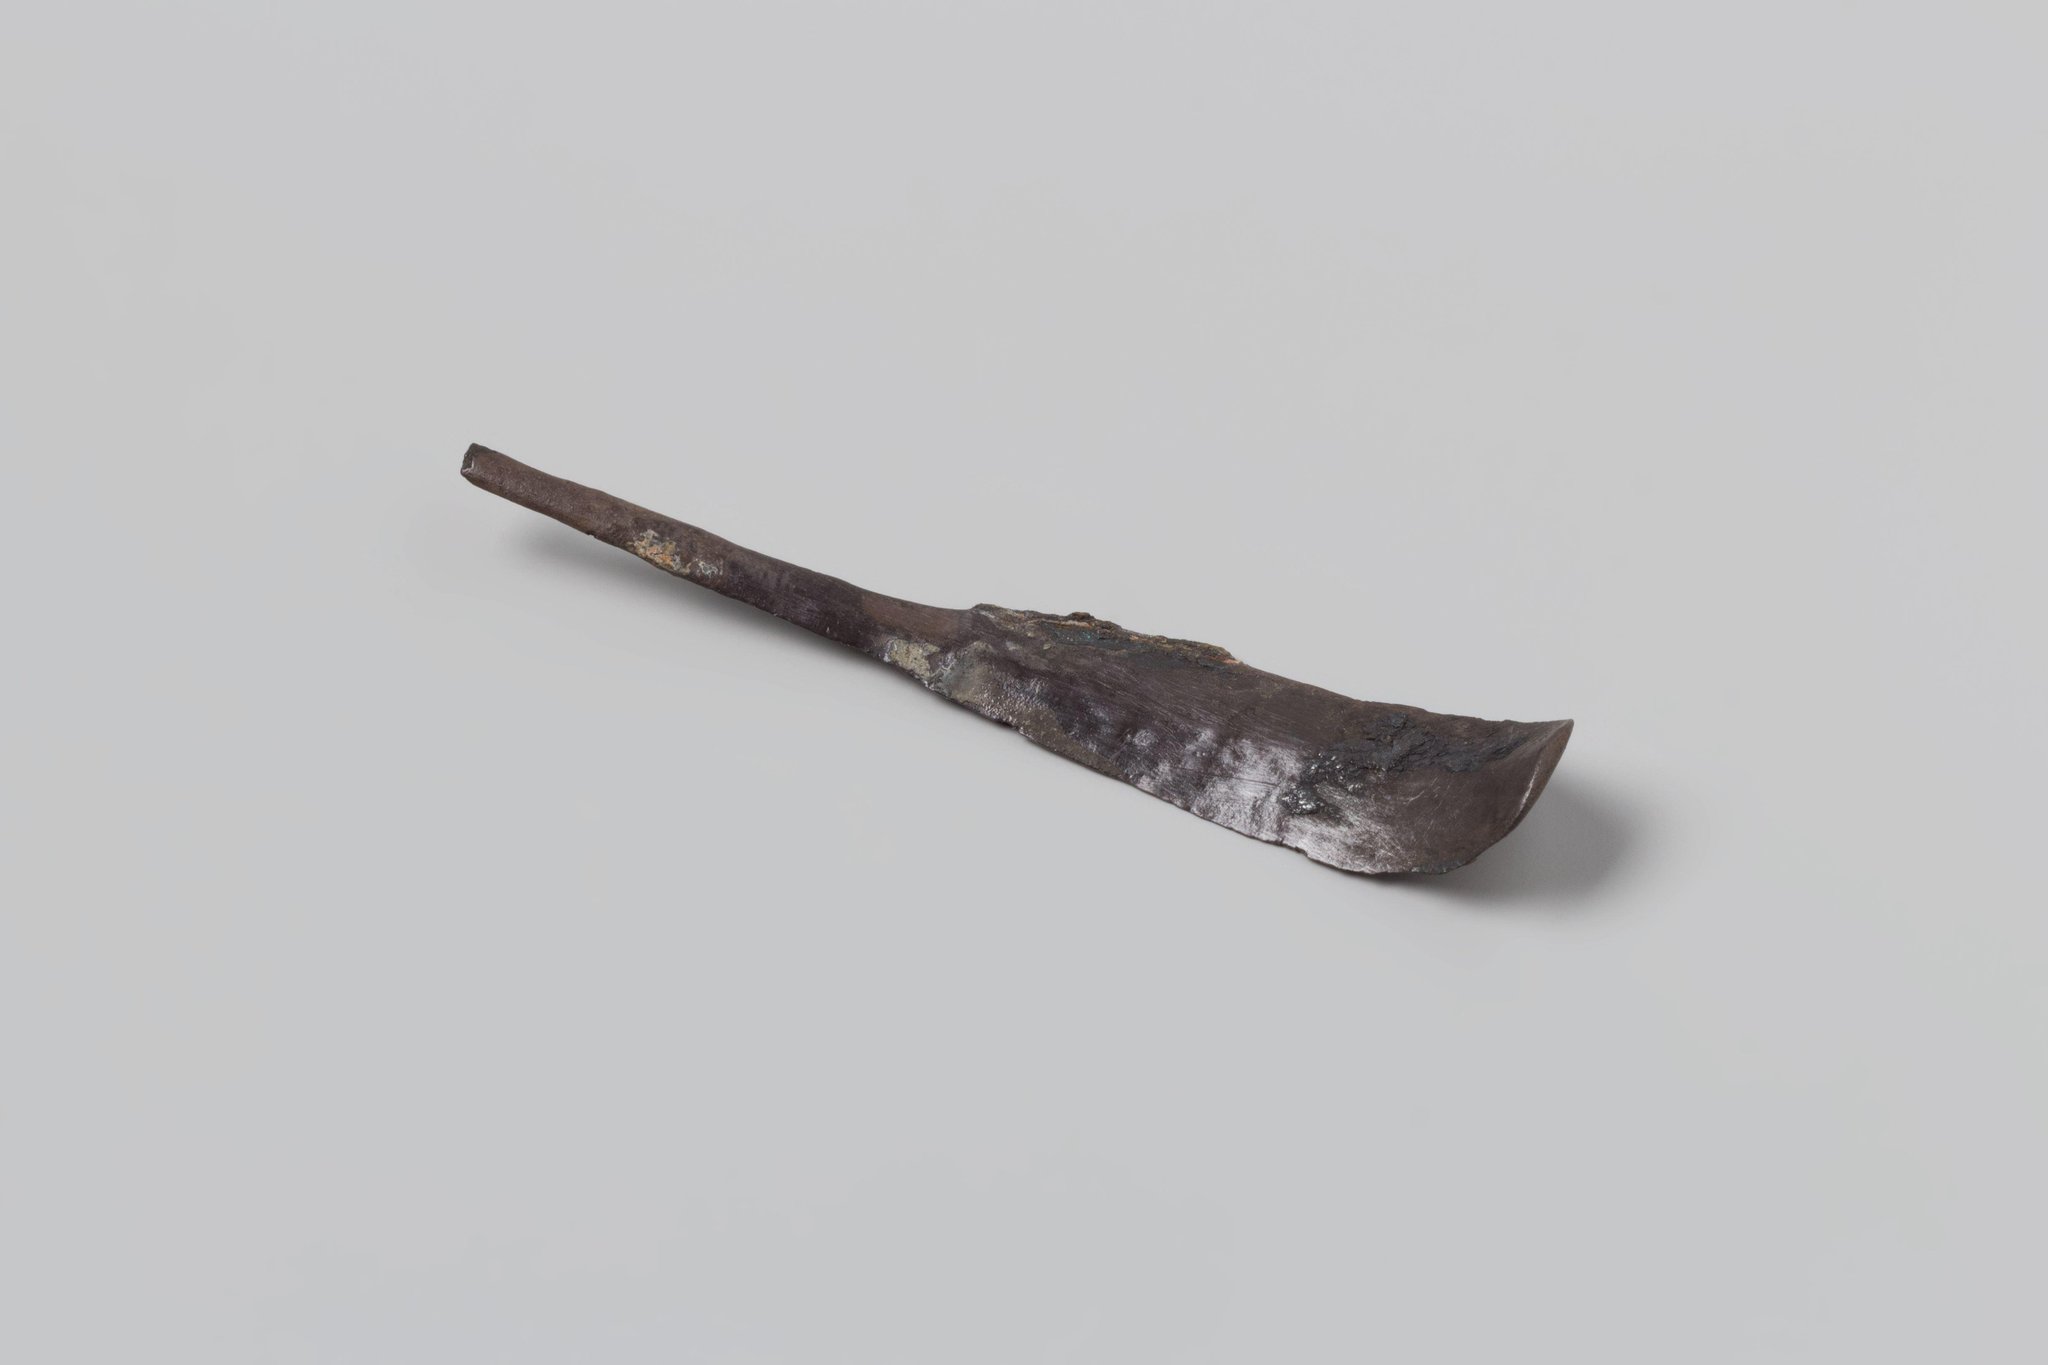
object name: fork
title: Steel van vork of lepel uit het wrak van de Oost-Indiëvaarder Hollandia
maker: Anonymous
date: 1700-1743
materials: silver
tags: verenigde oostindische compagnie, hollandia (schip), annet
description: Cutlery, fragment: stem of fork or spoon; (1)fragm, end, eroded, sim. NG 1980-27H1089/1291 ( -1.1./-4.1.), no marks legible.